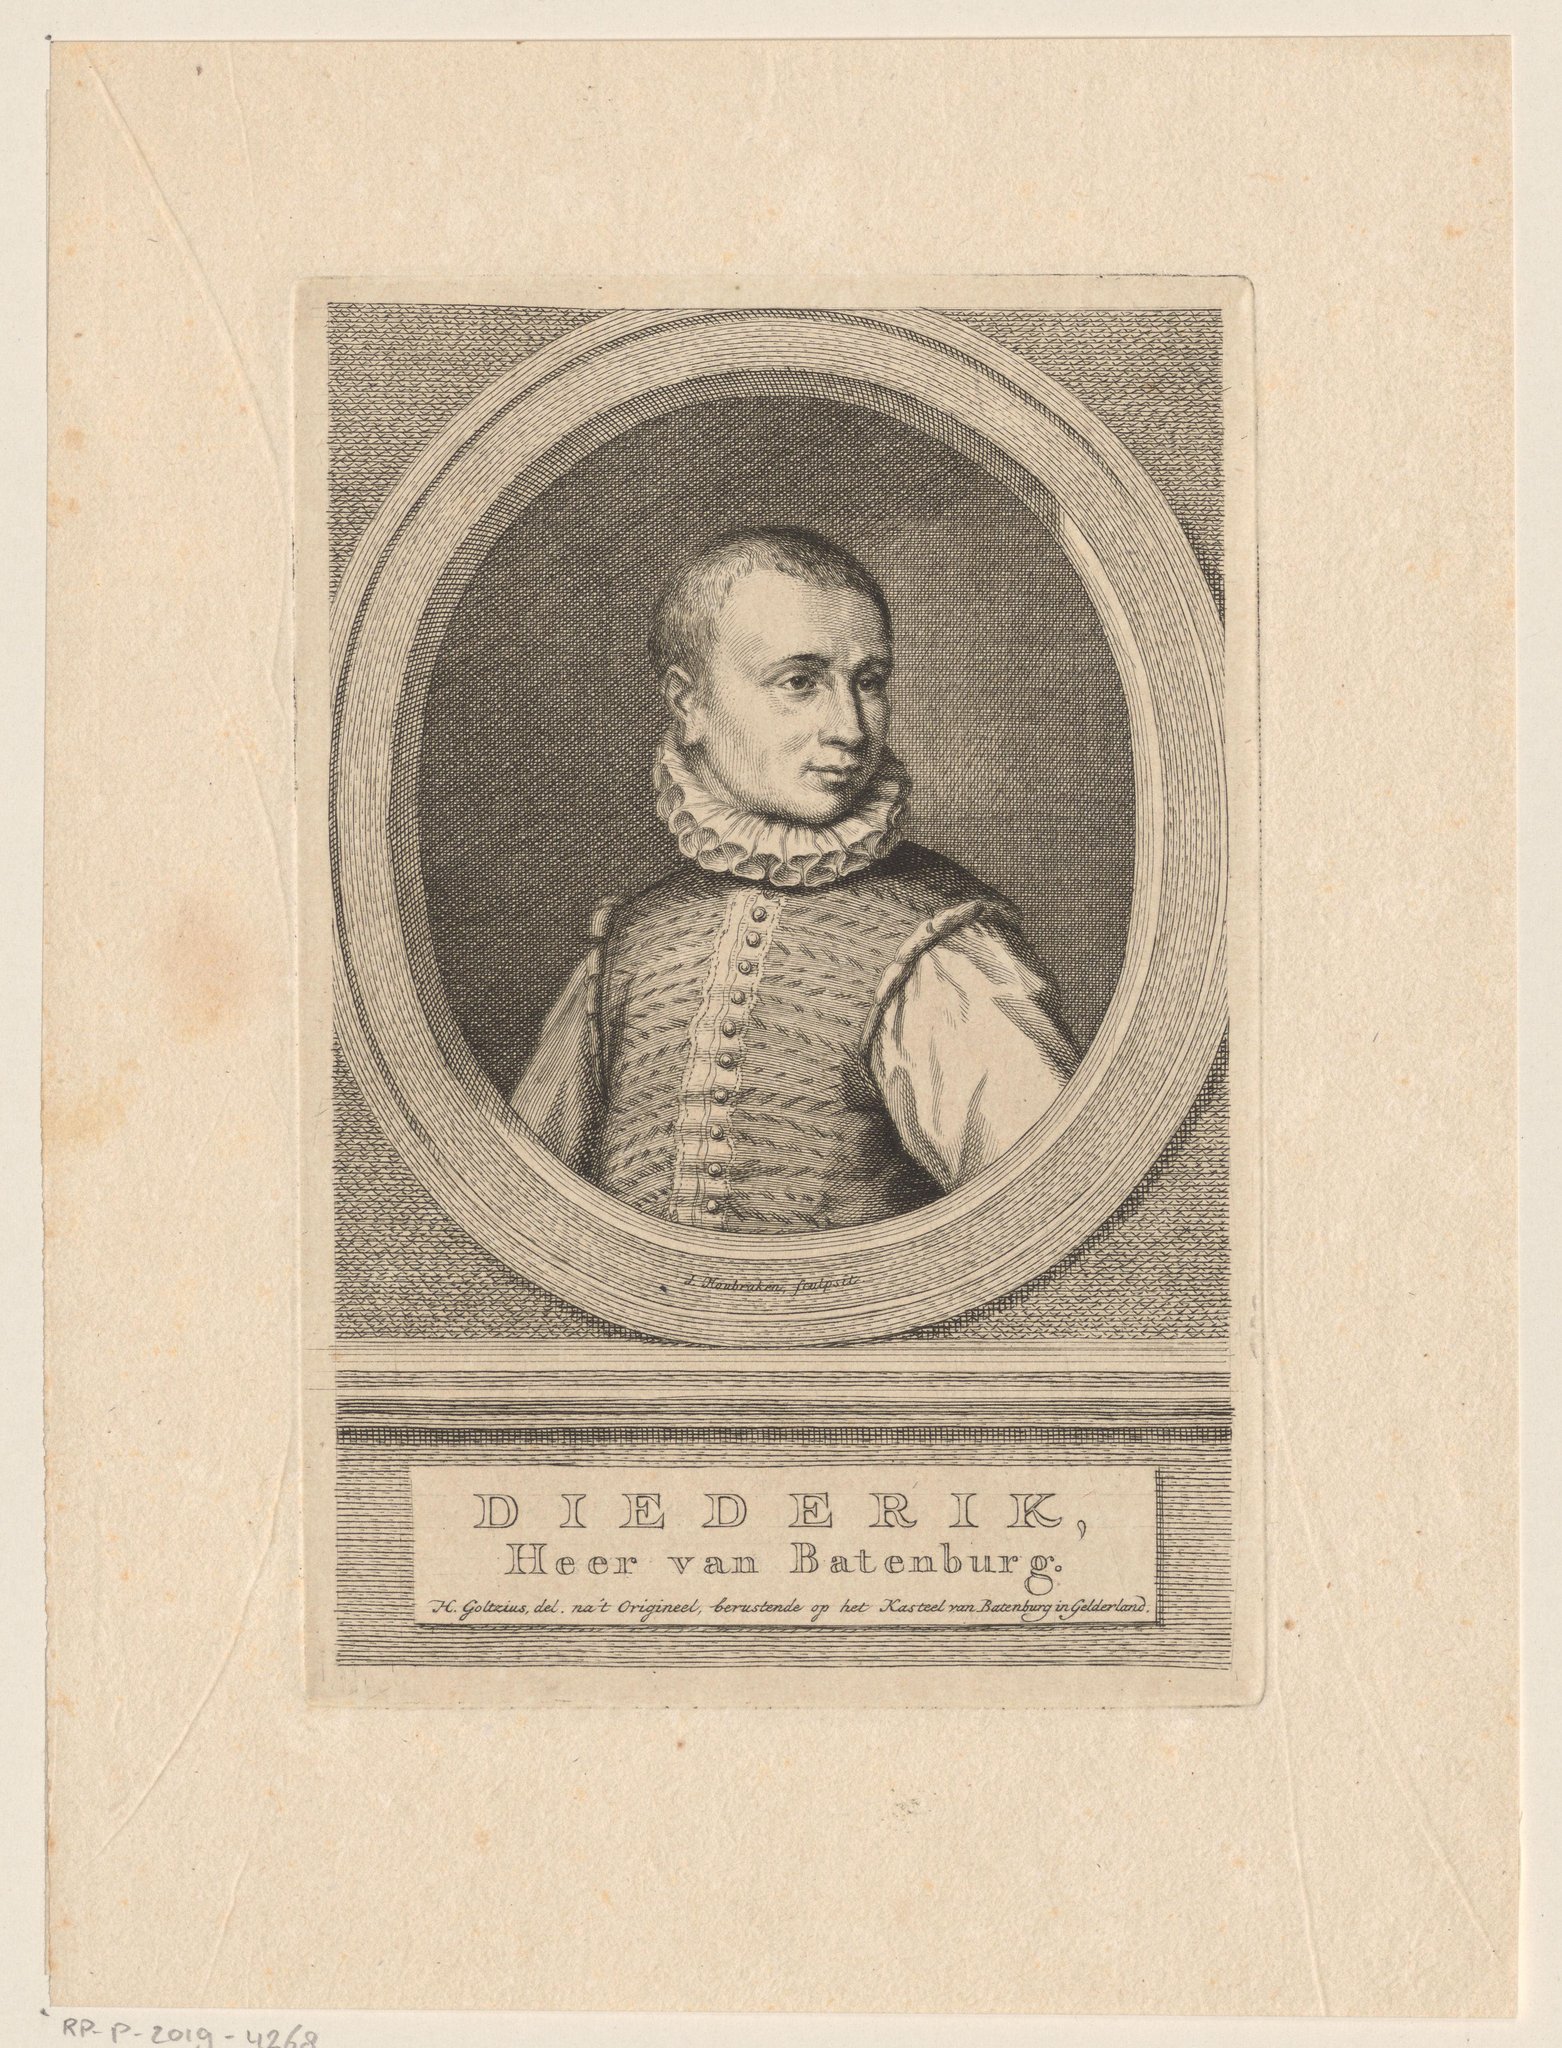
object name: print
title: Portret van Diederik van Bronckhorst-Batenburg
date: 1749-1759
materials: paper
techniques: engraving, etching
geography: amsterdam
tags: brussels, historical persons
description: Prent bedoeld als aanvulling op: Wagenaar, Jan. Vaderlandsche historie, vervattende de geschiedenissen der nu Vereenigde Nederlanden, inzonderheid die van Holland (...), 21 dln. Amsterdam: Isaak Tirion, 1749-1759. Prent uitgegeven in 1796 door Johannes Allart te Amsterdam.